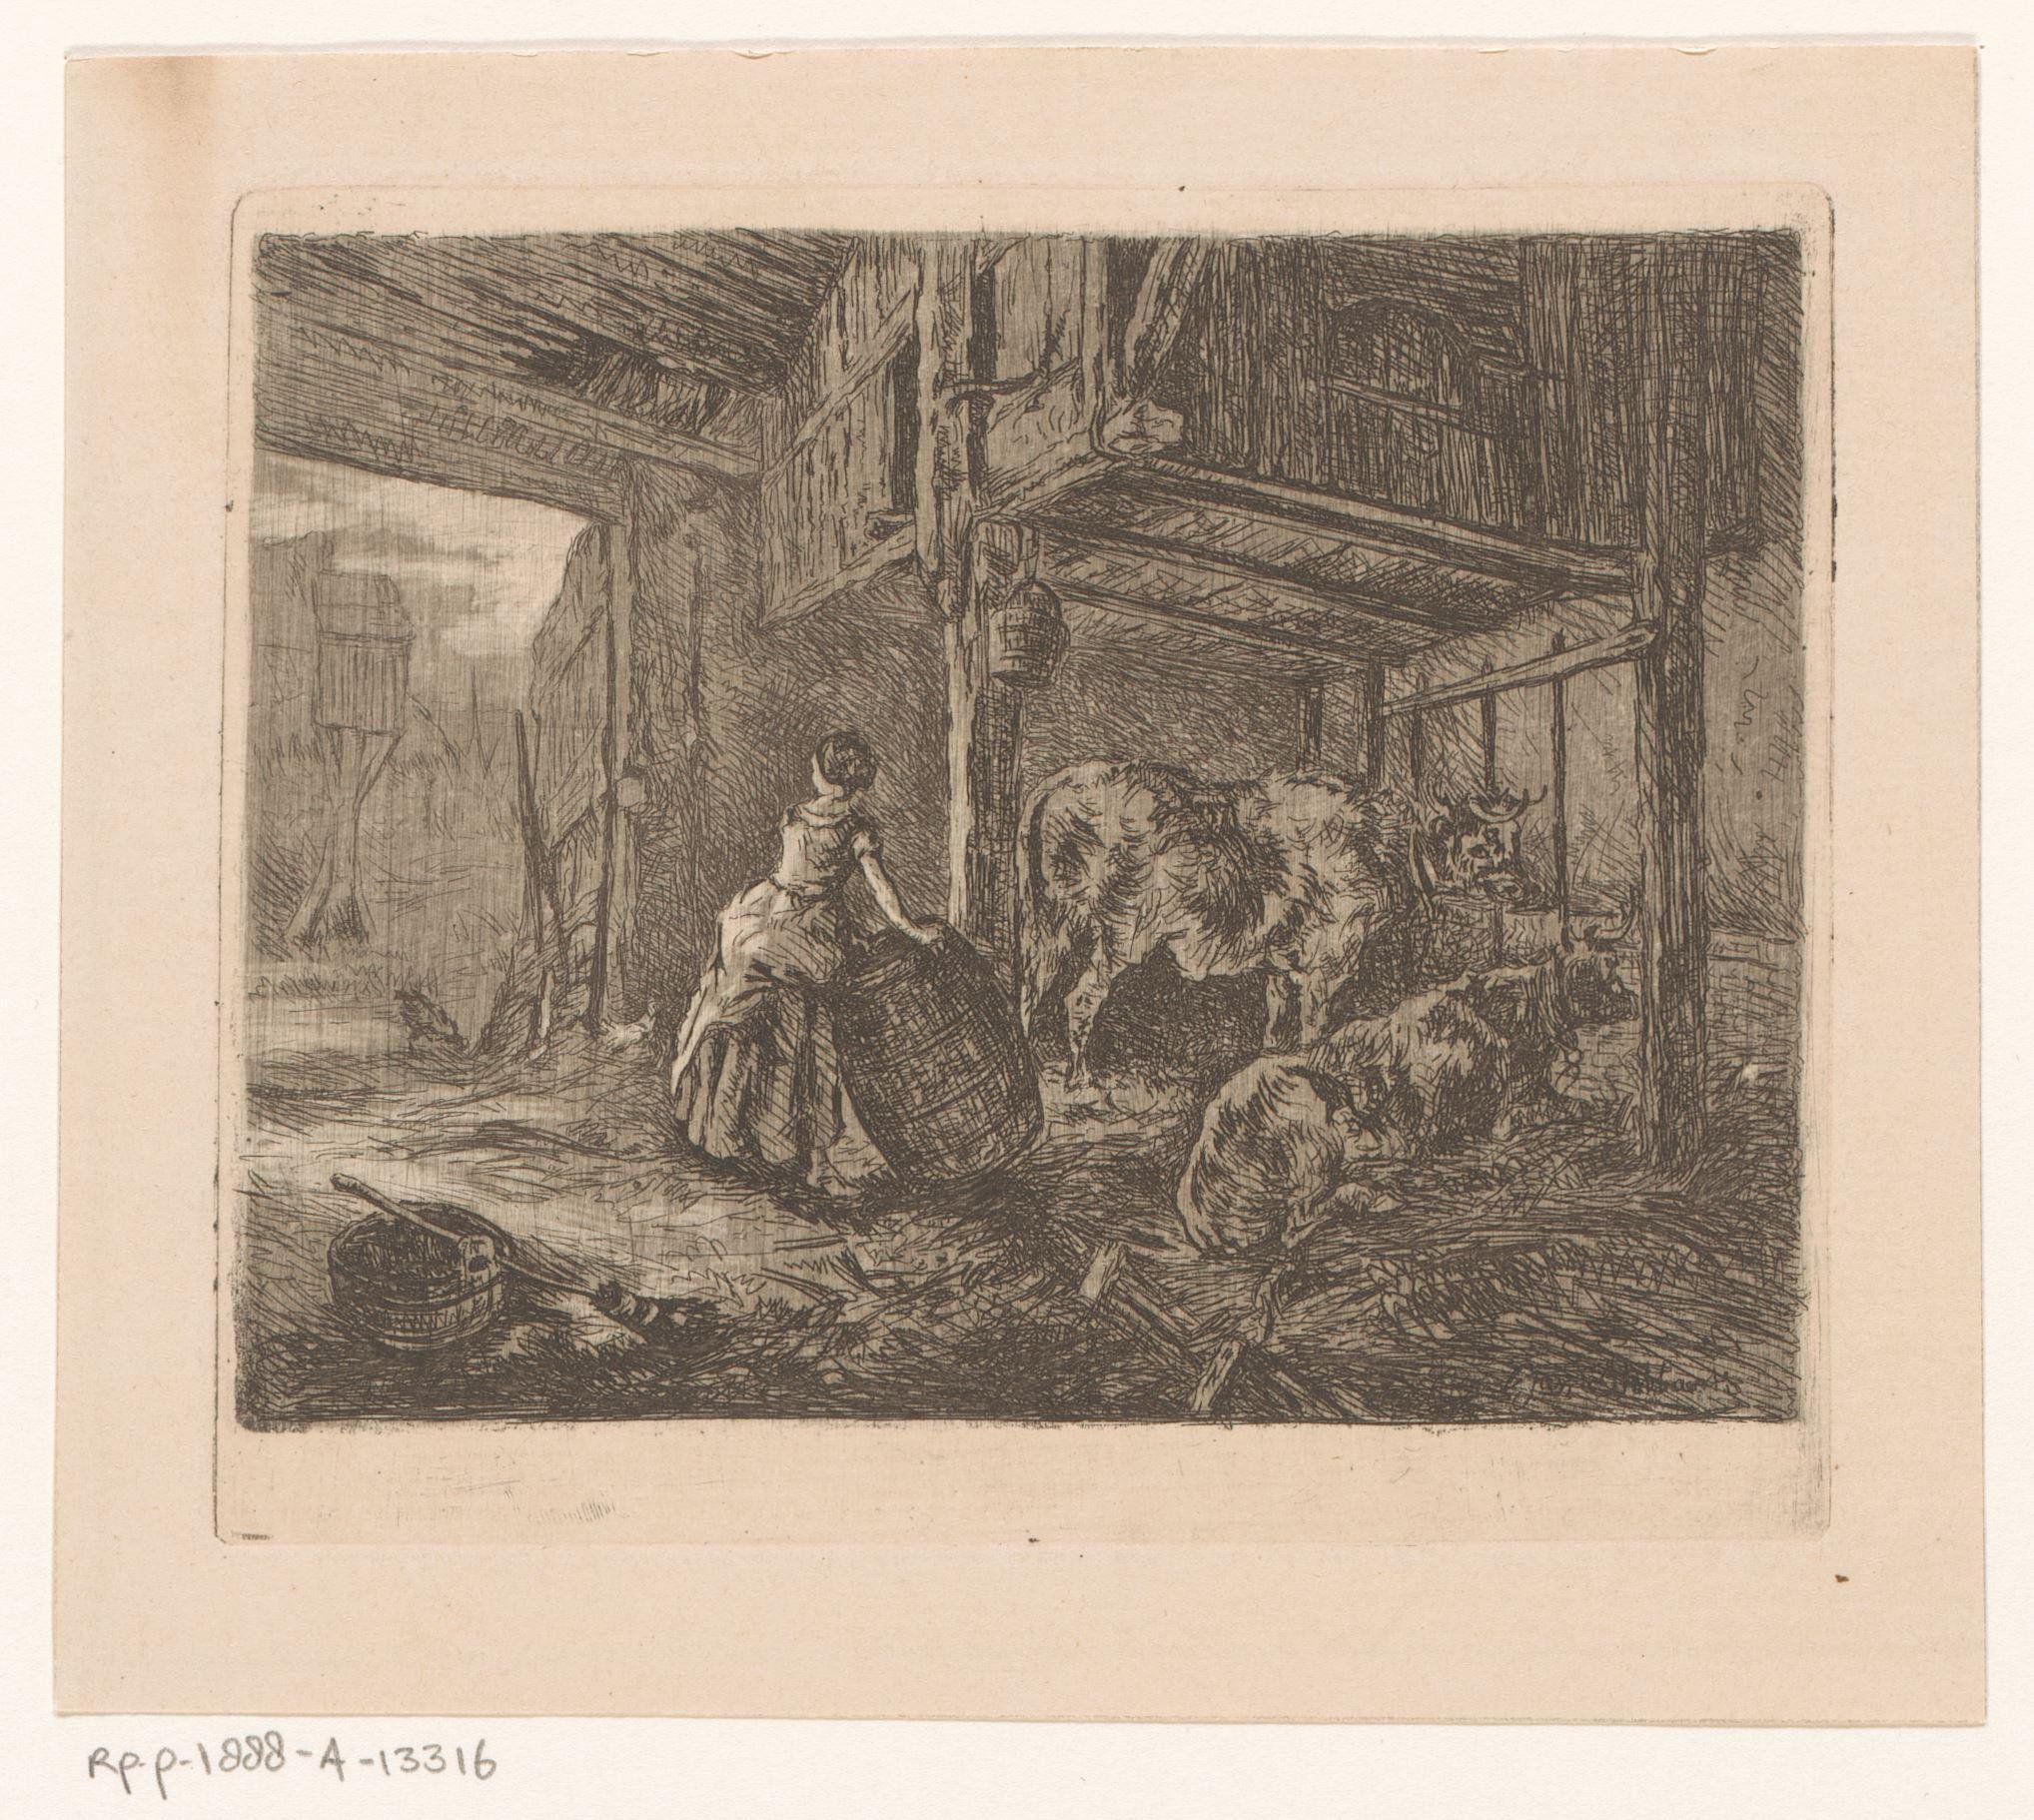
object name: print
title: Vrouw met ton in een stal met twee koeien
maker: jan stobbaerts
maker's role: draughtsman, print maker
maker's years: 1838-1914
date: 1848-1879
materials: paper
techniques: etching, intaglio, letterpress printing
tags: wooden container: barrel, cask, bucket, cow, adult woman, stall, stable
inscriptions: collector's mark: Lugt 2228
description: Mogelijk van hetzelfde blad als RP-P-1890-A-15686 en RP-P-1888-A-13328; de tabellen op de verso's lijken bij elkaar te horen.